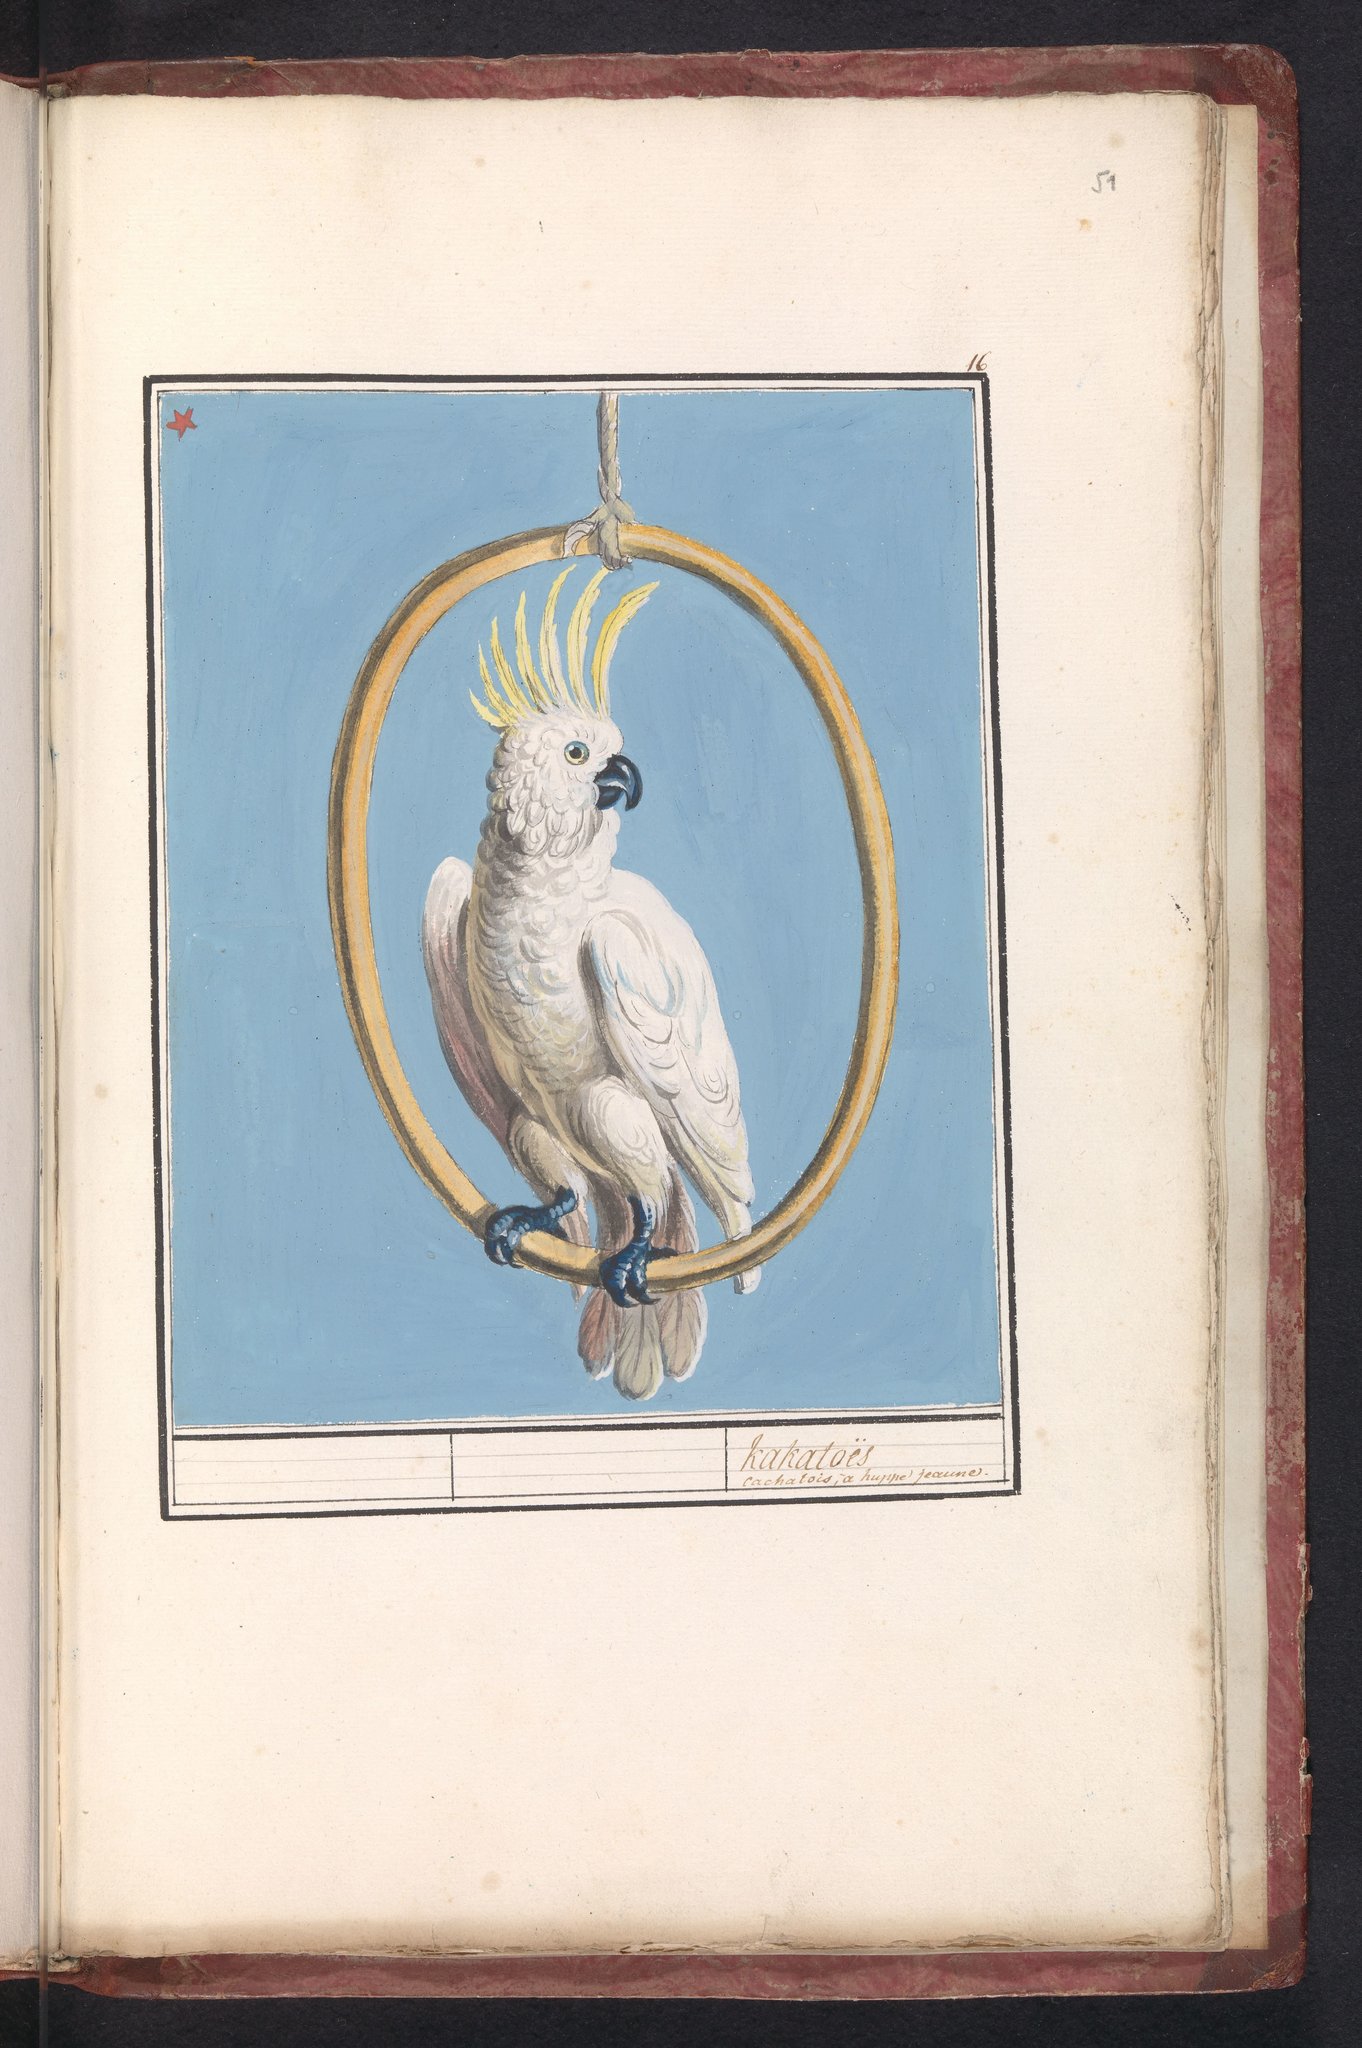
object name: drawing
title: Kakatoës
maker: Anonymous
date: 1790-1814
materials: paint, ink, paper, pencil, watercolor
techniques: brush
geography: southern netherlands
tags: ornamental birds: cockatoo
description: Grote geelkuifkaketoe, zittend in een hoepel. Genummerd rechtsboven: 16. Linksboven gemerkt met een rood sterretje. Onderdeel van het tweede album met tekeningen van vogels. Vierde van twaalf albums met tekeningen van dieren, vogels en planten bekend rond 1600, gemaakt in opdracht van keizer Rudolf II. Met toelichting in Nederlands, Latijn en Frans.